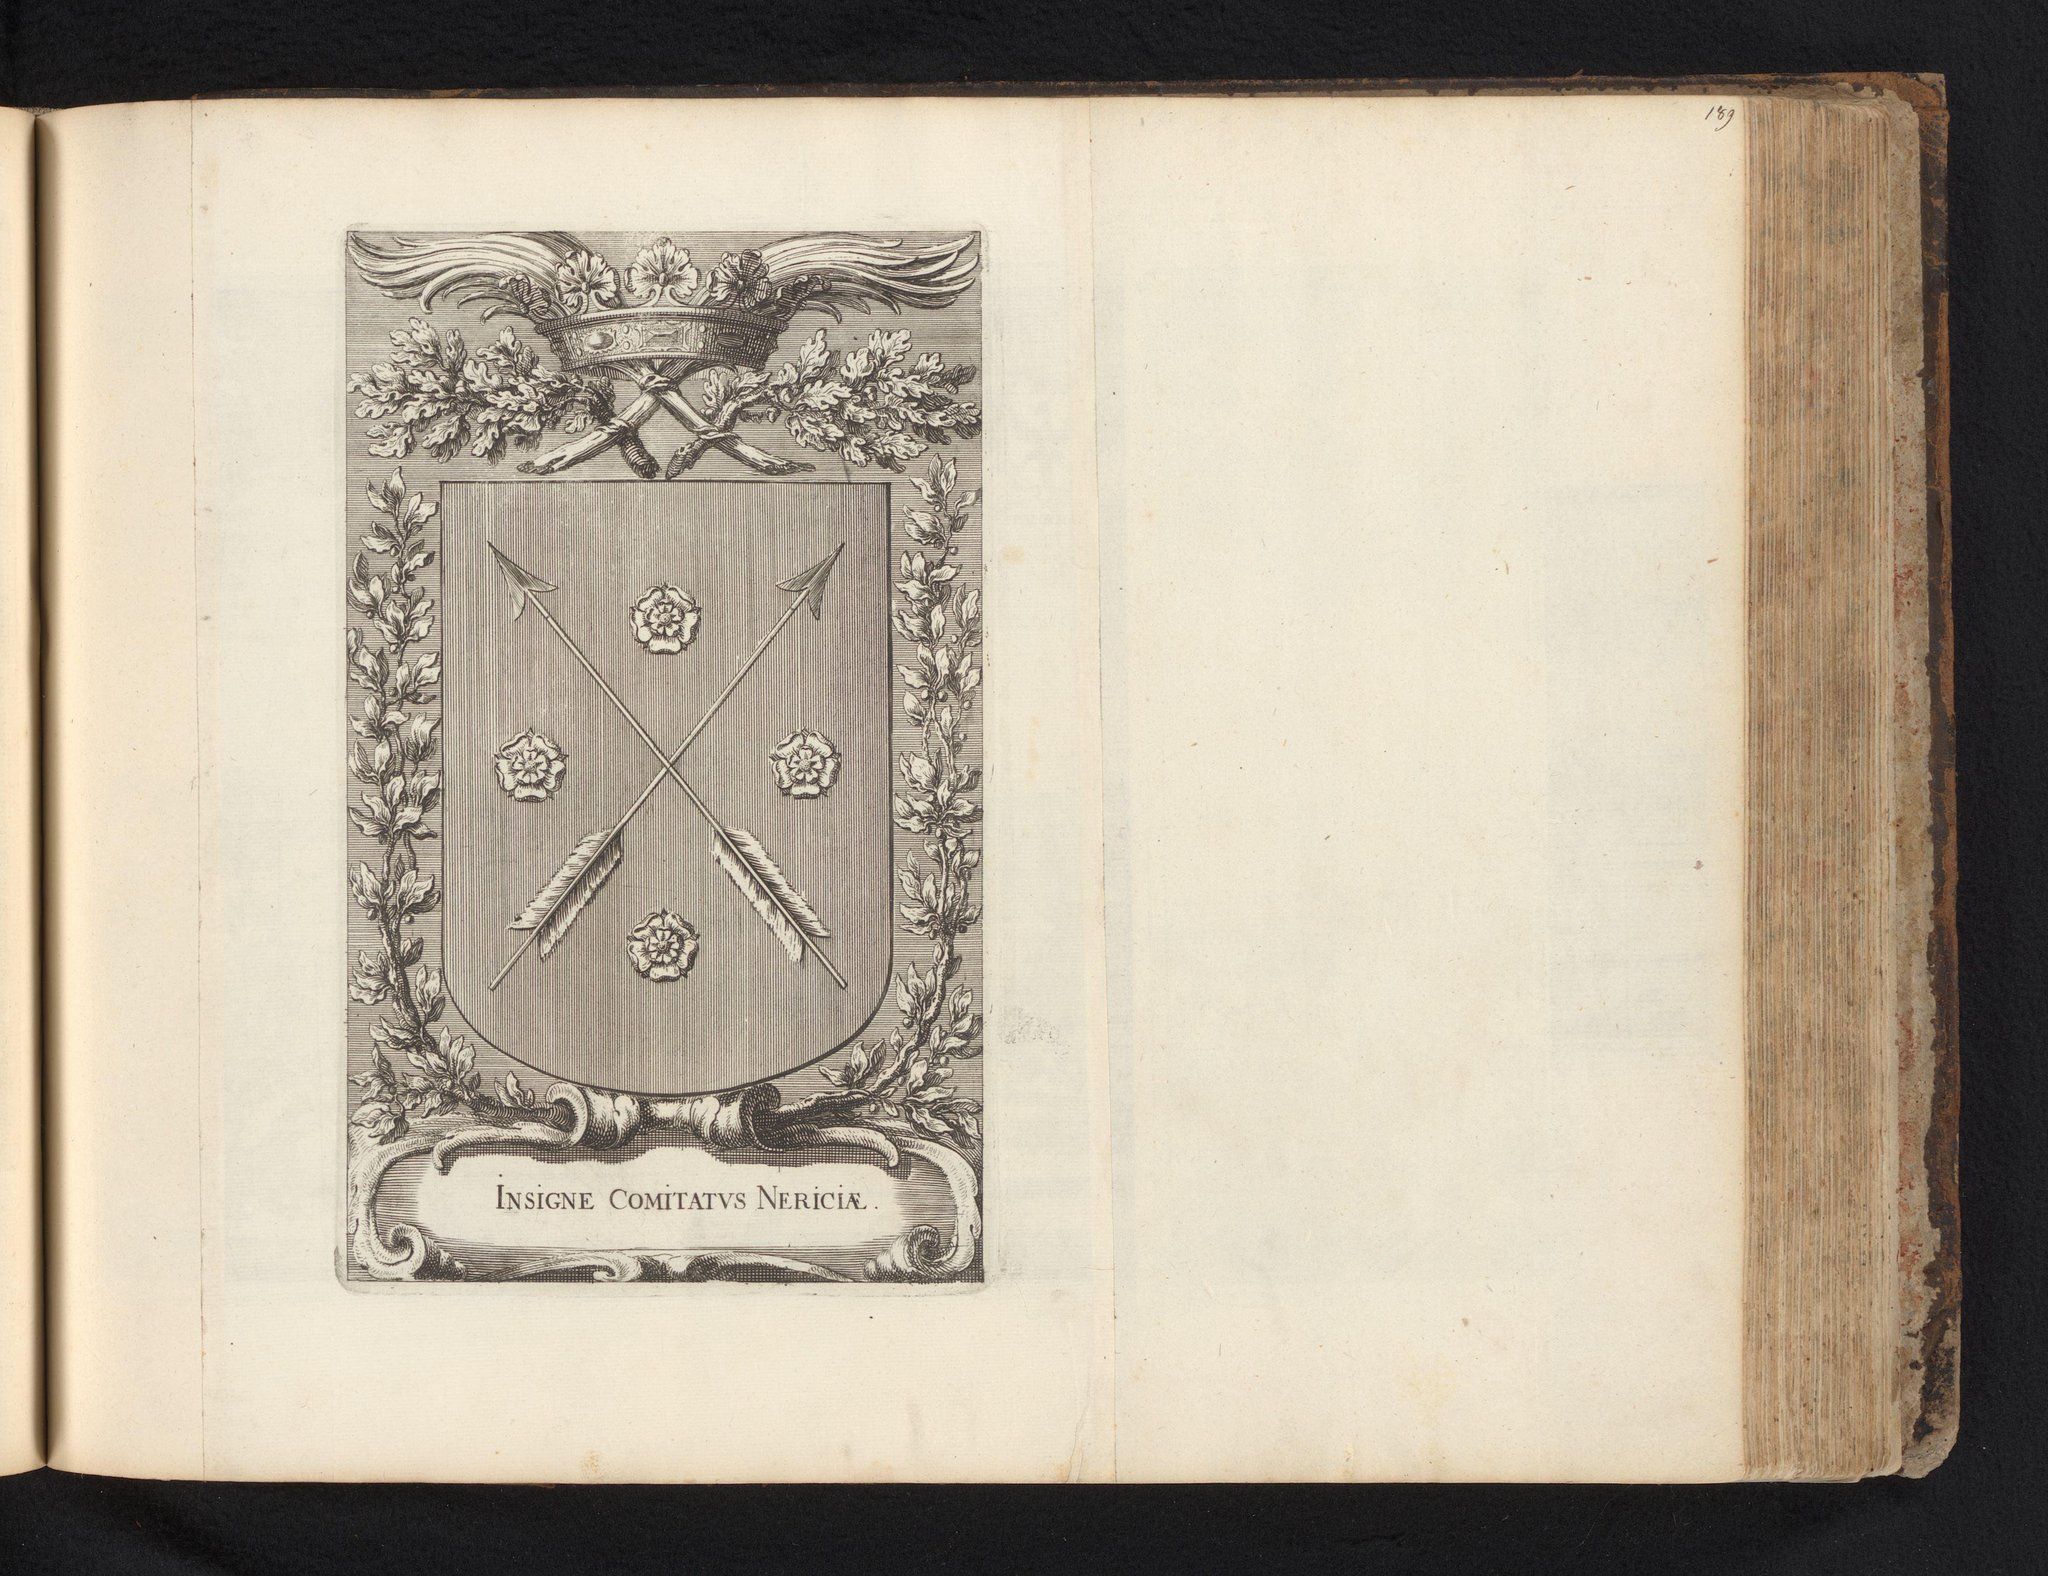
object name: print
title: Insigne Comitatus Nericiae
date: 1696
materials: paper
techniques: etching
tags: coat of arms (as symbol of the state, etc.)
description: Kungliga Biblioteket, 'Suecia': http://www.kb.se/samlingarna/Kartor-bilder/Suecia-antiqua/ (geraadpleegd november 2016).